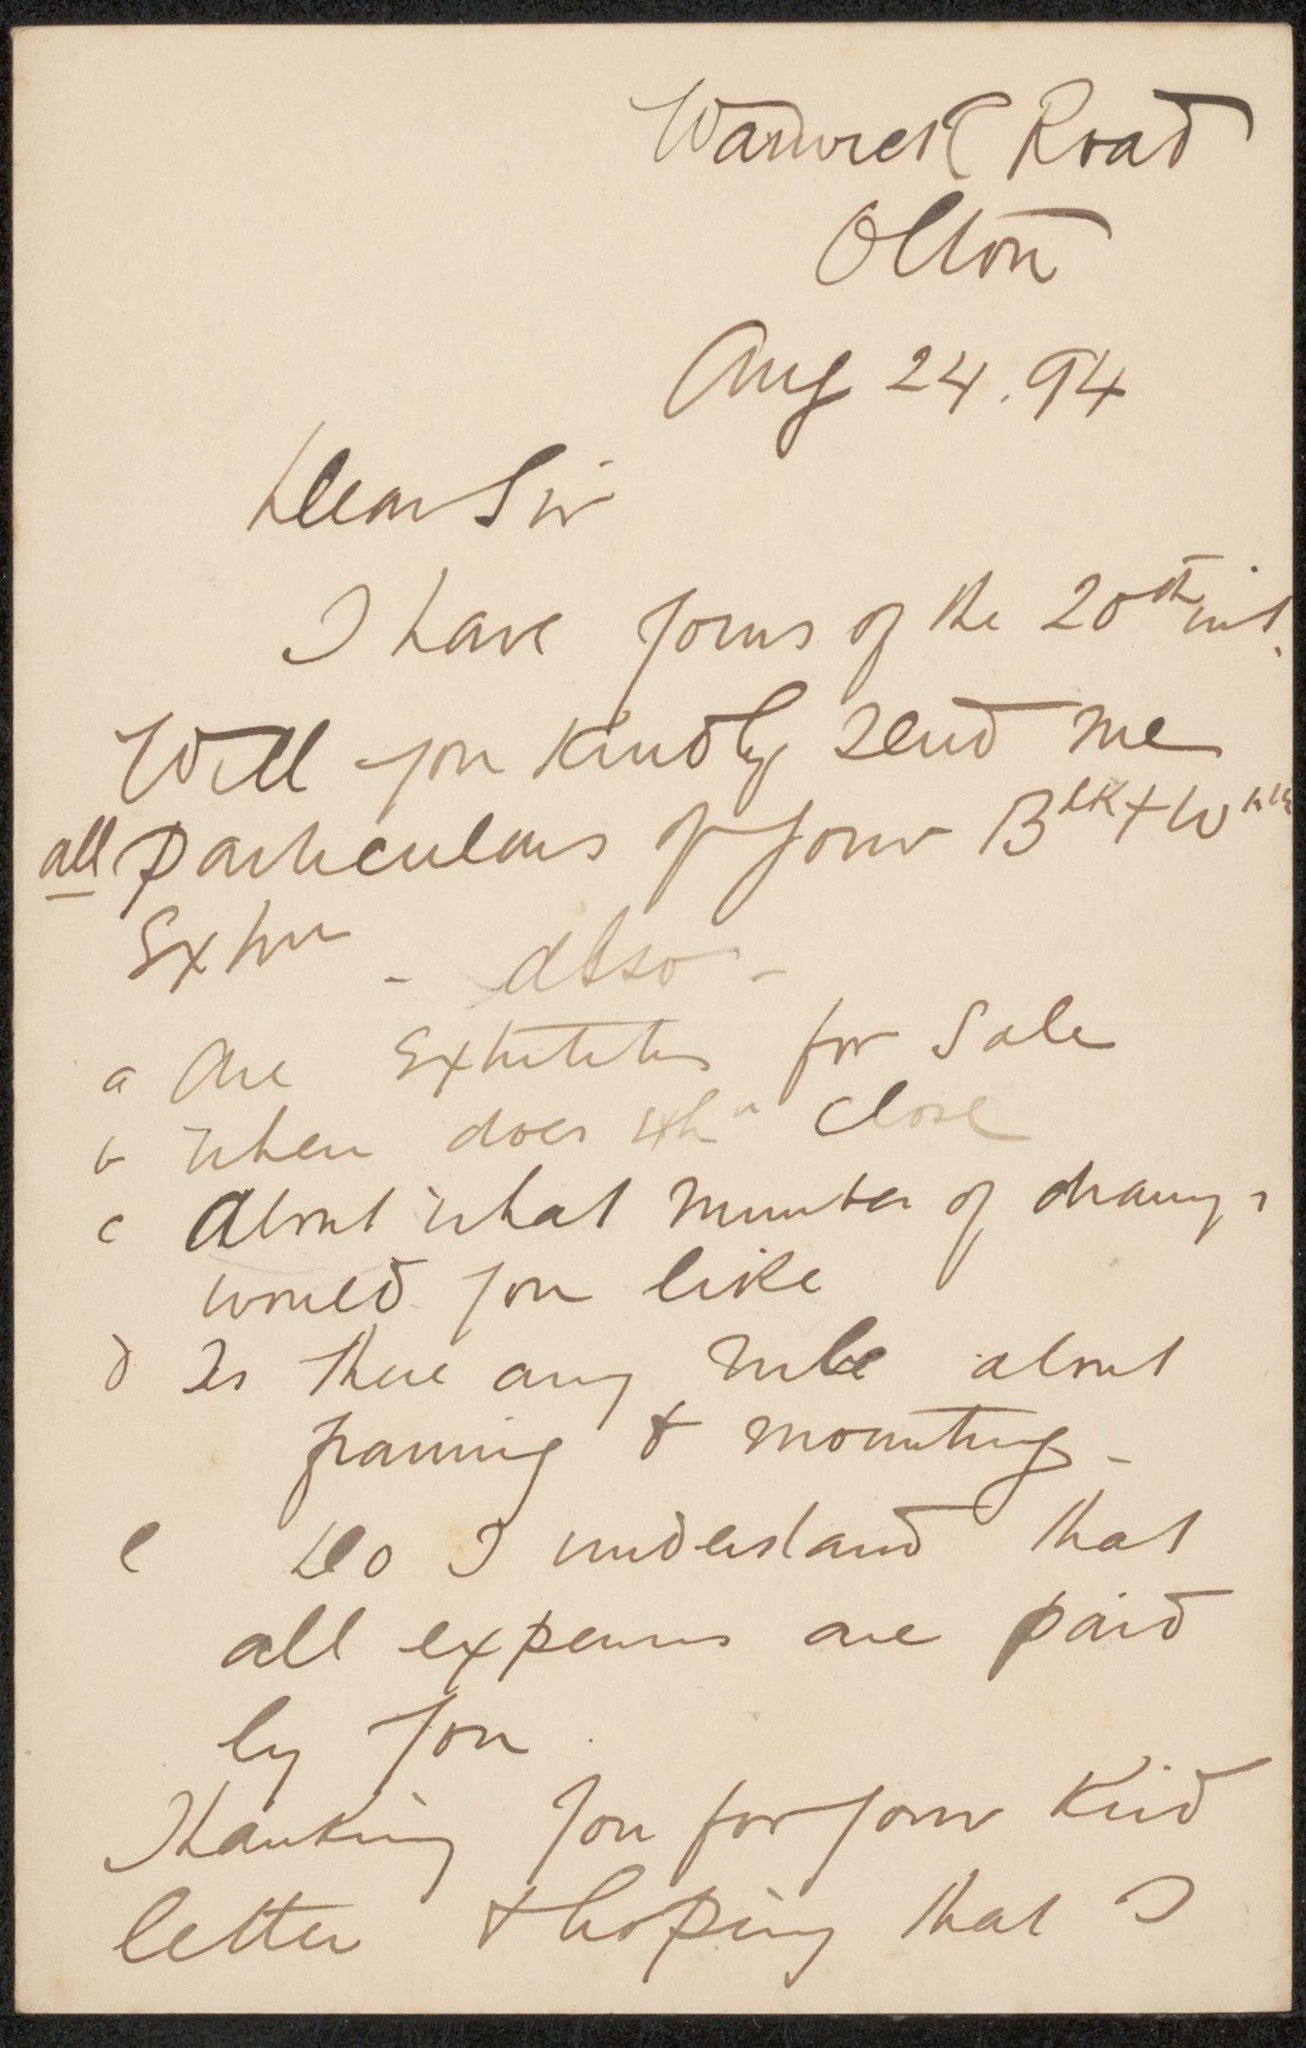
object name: letter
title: Brief aan Philip Zilcken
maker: arthur gaskin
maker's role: painter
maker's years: 1862-1928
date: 1894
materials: ink, paper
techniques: pen, writing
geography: warwickshire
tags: the hague, draughtsman, philip zilcken, temporary exhibition, 'salon', money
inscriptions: collector's mark: ‘RPK’, watermark